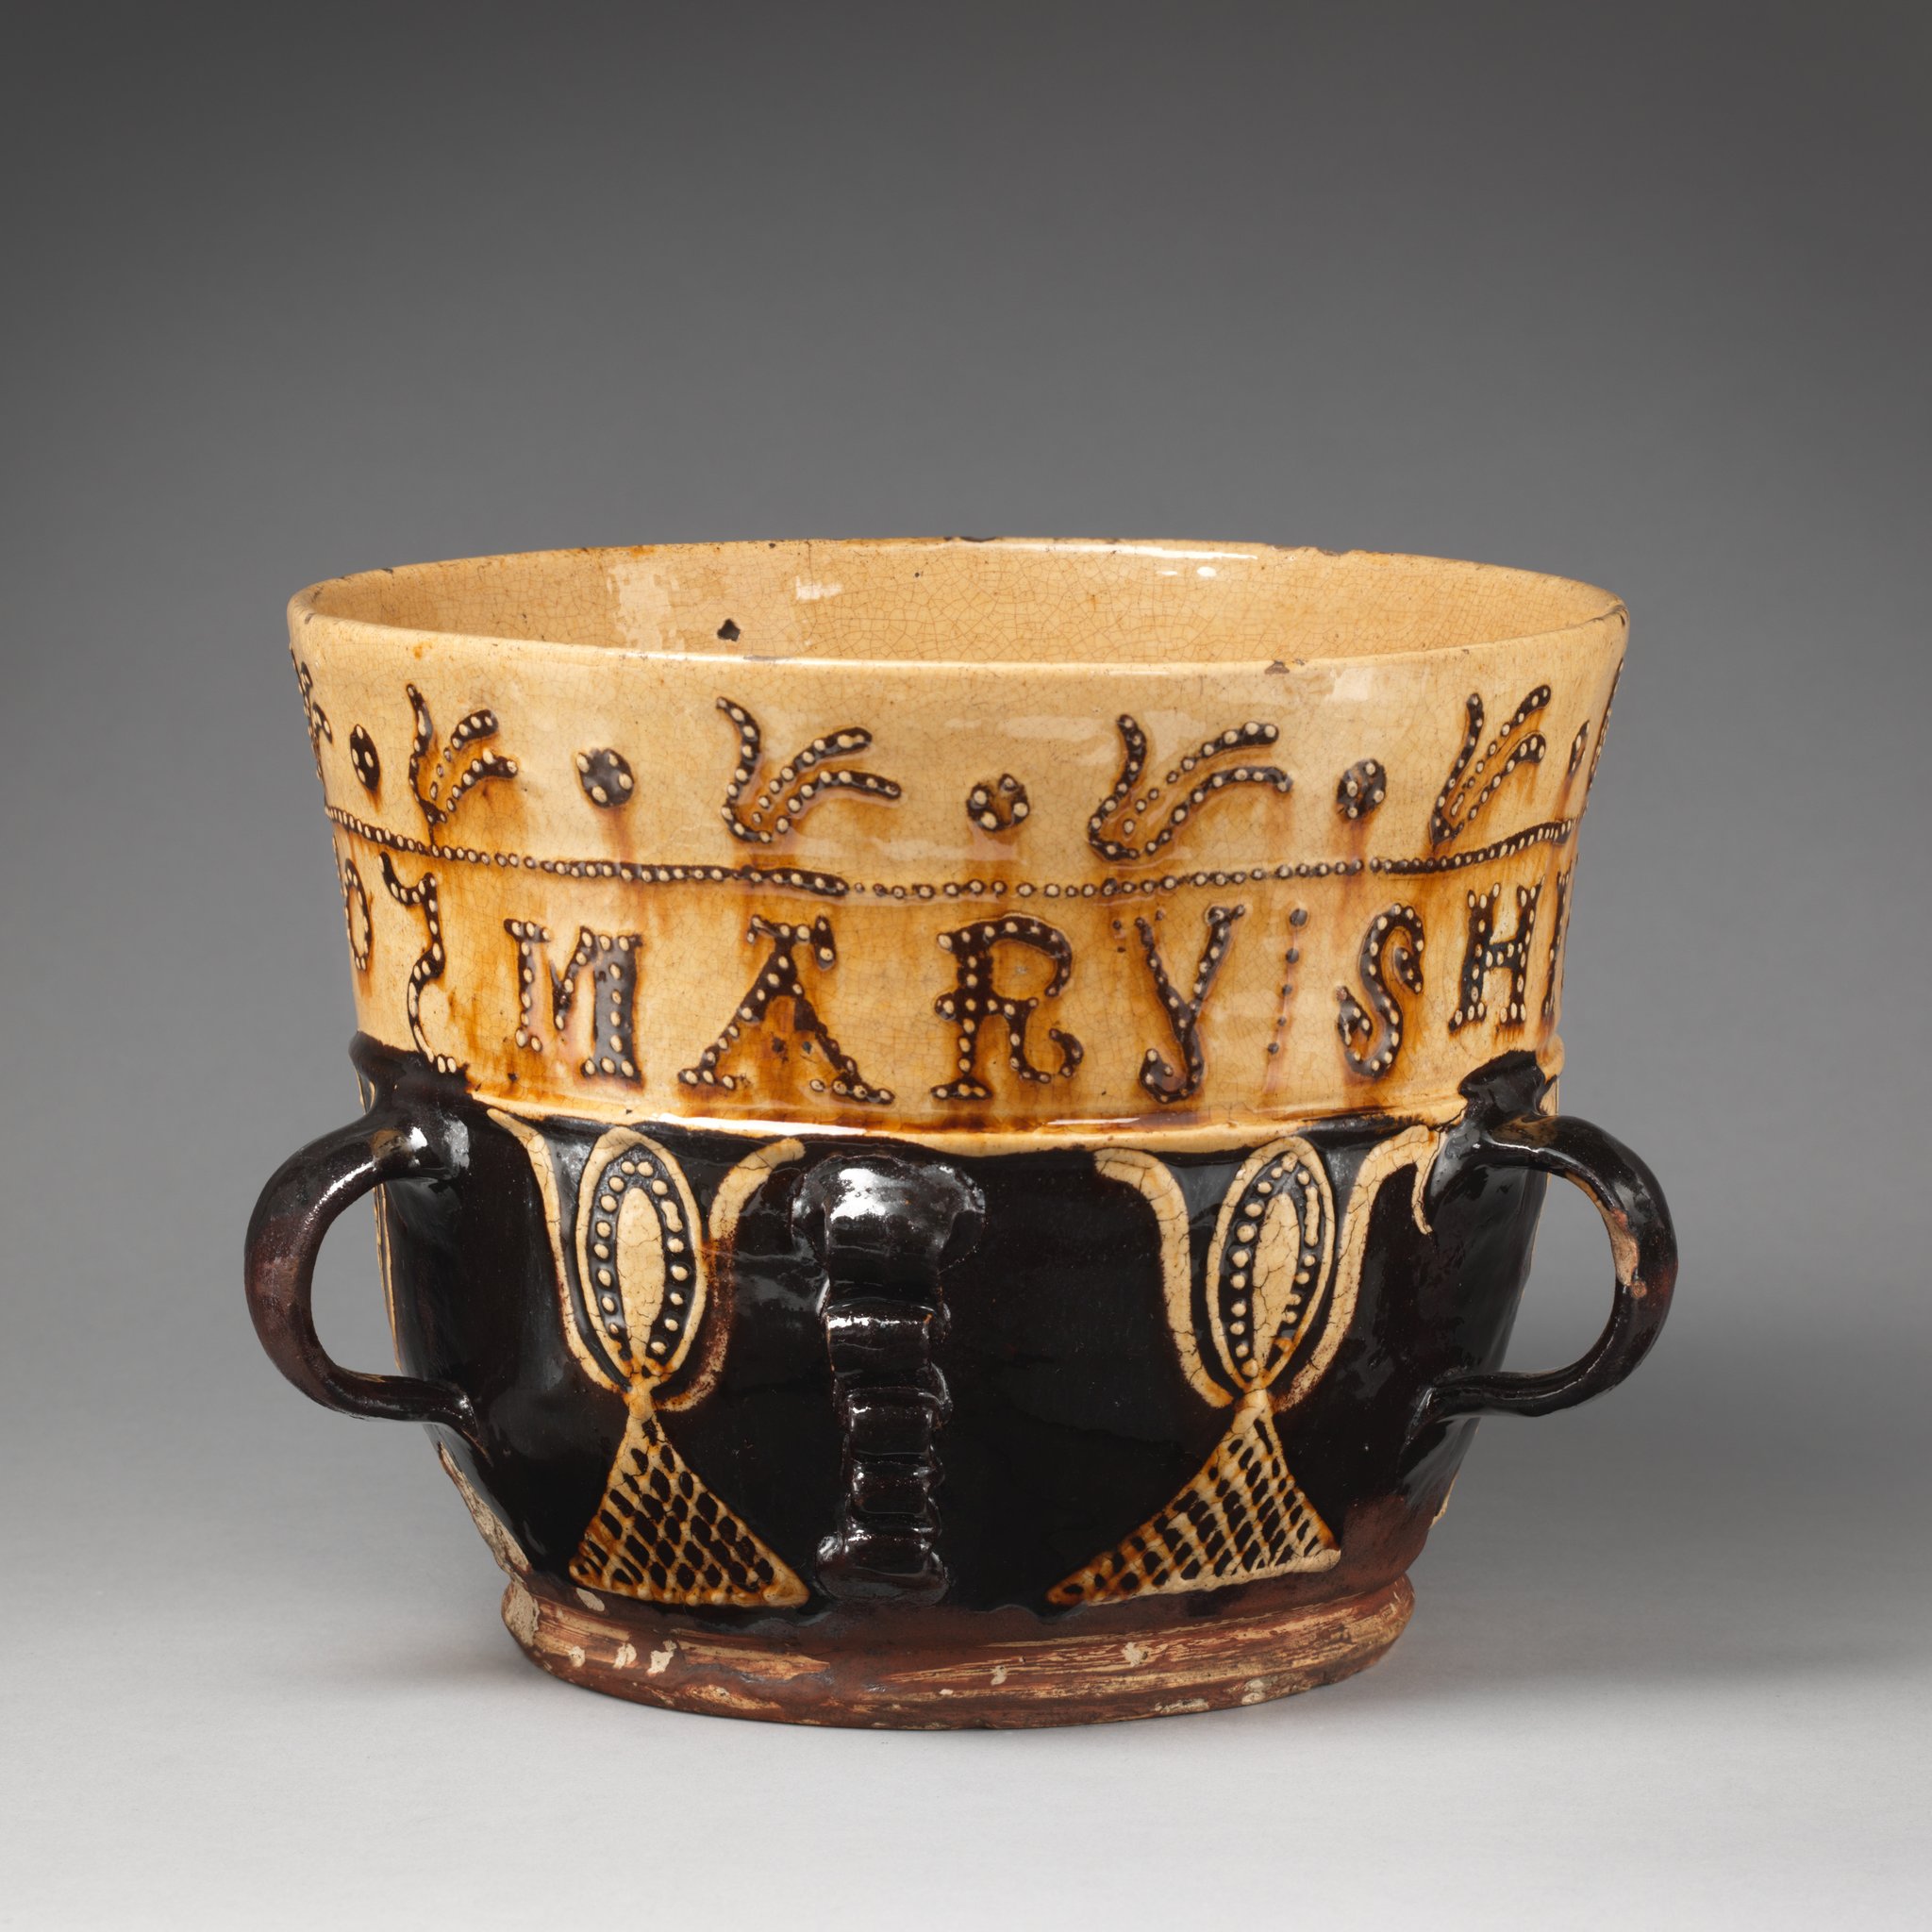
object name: posset pot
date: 1705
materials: earthenware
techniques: glazing